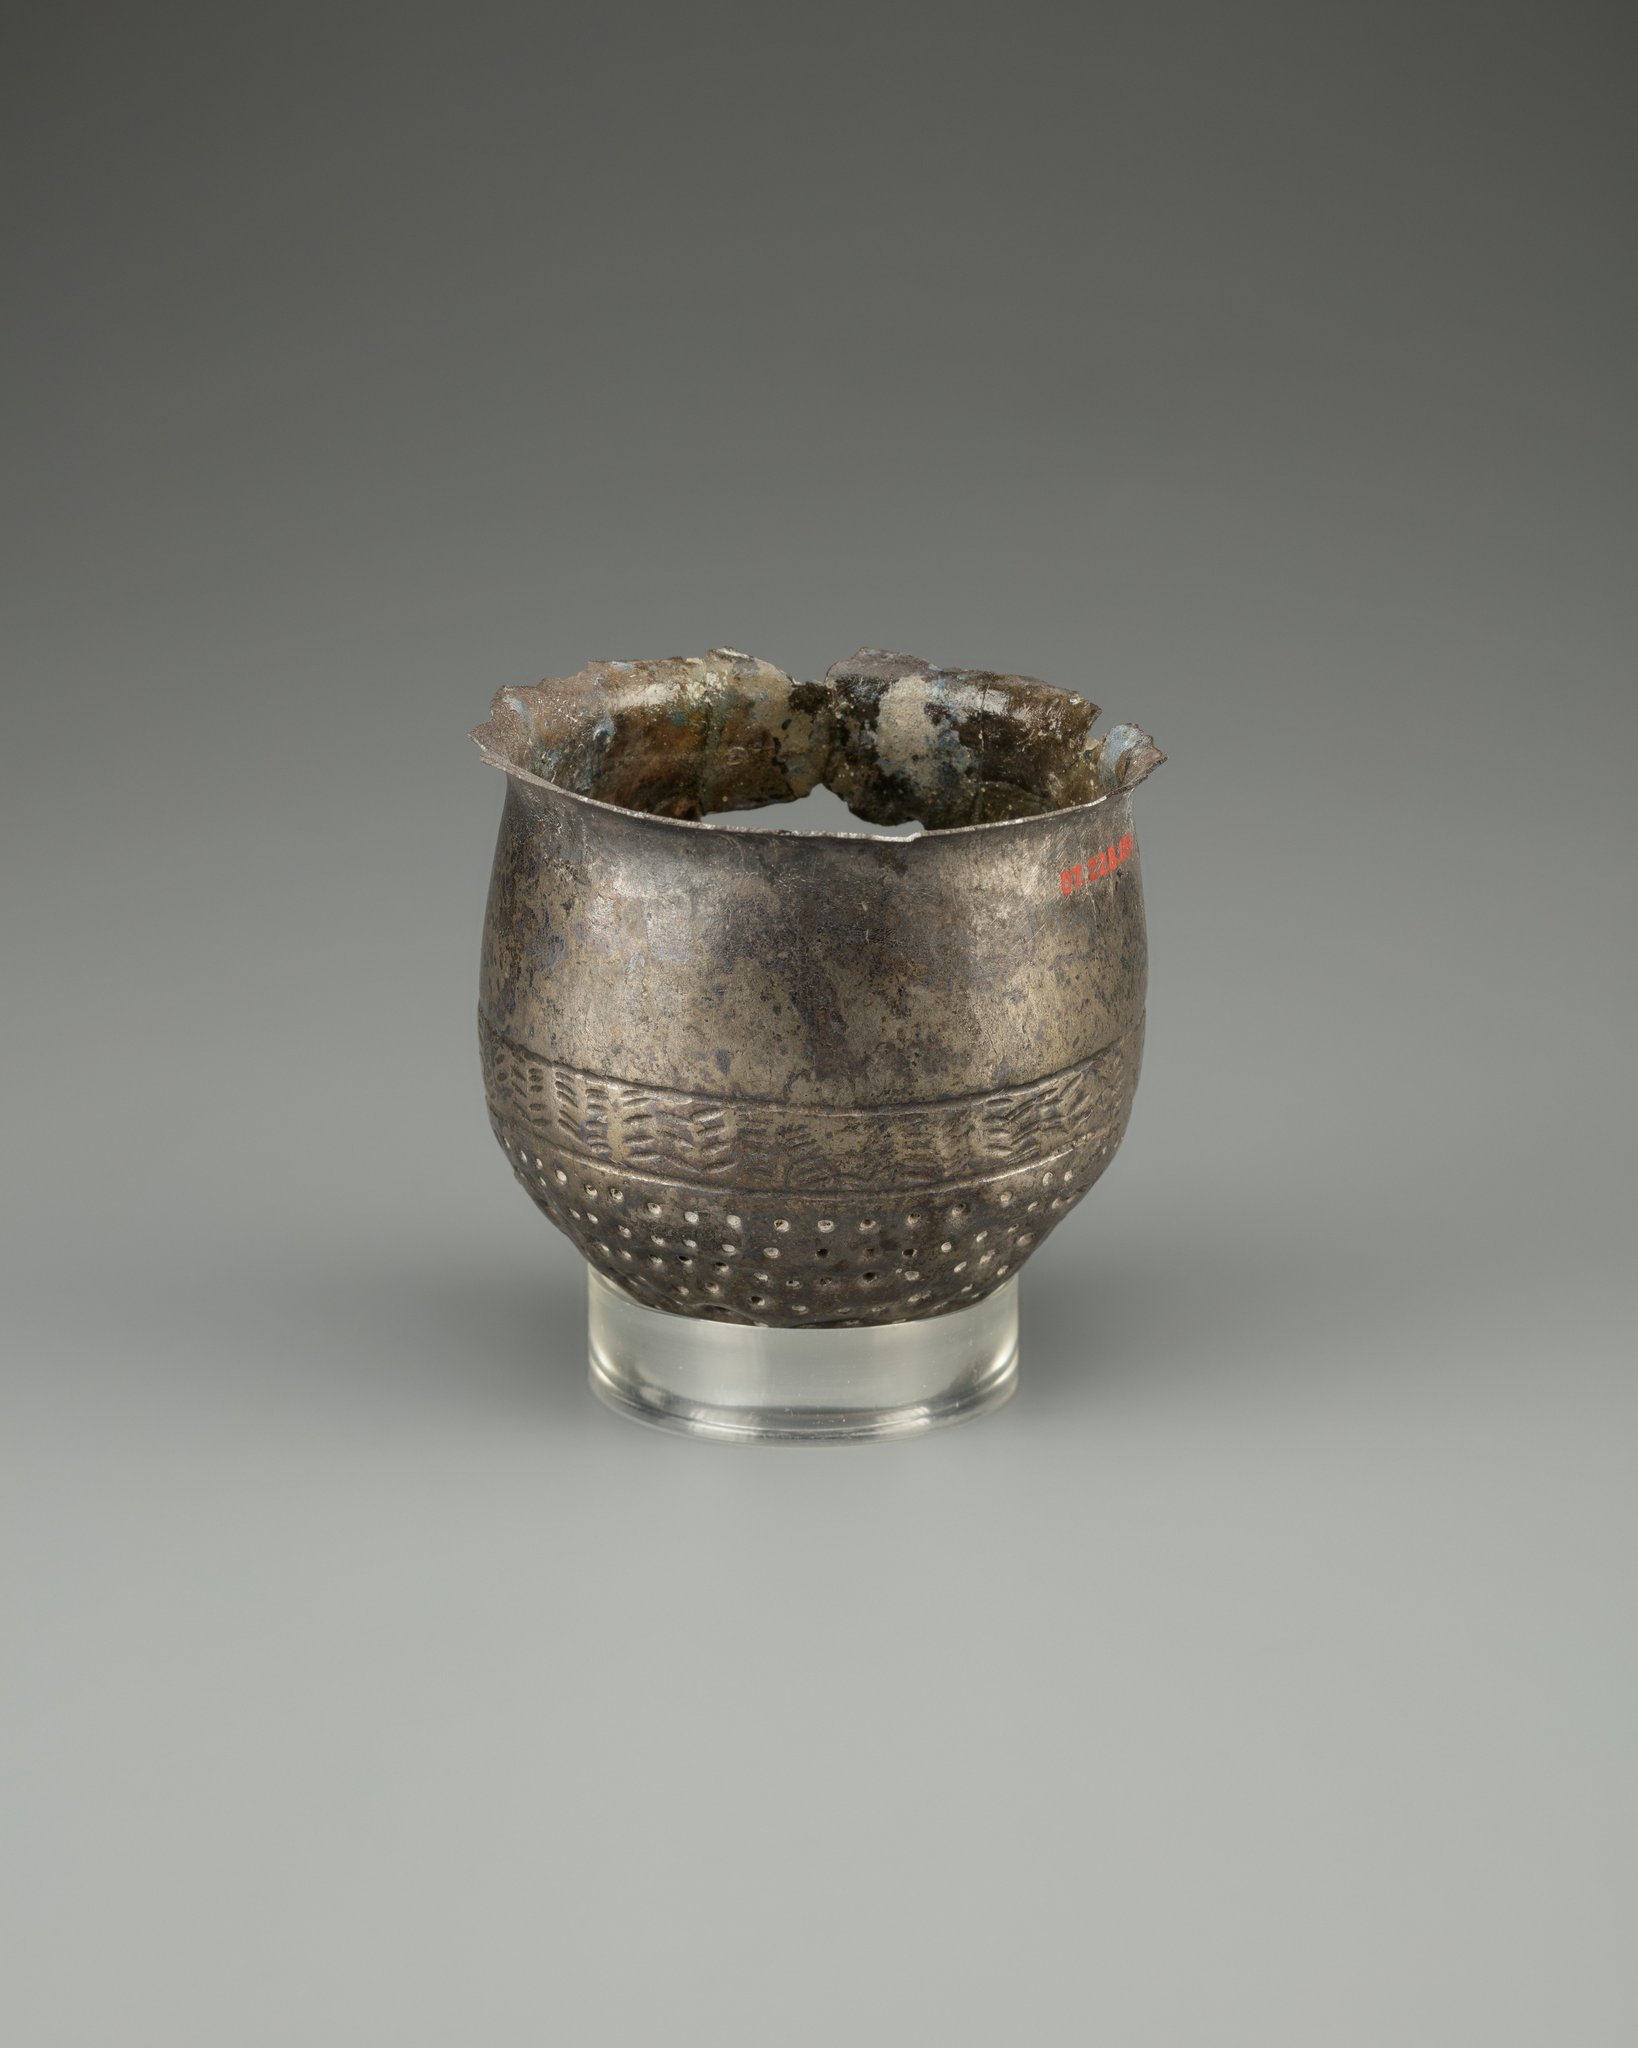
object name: strainer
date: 1279-1213 BCE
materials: silver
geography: egypt